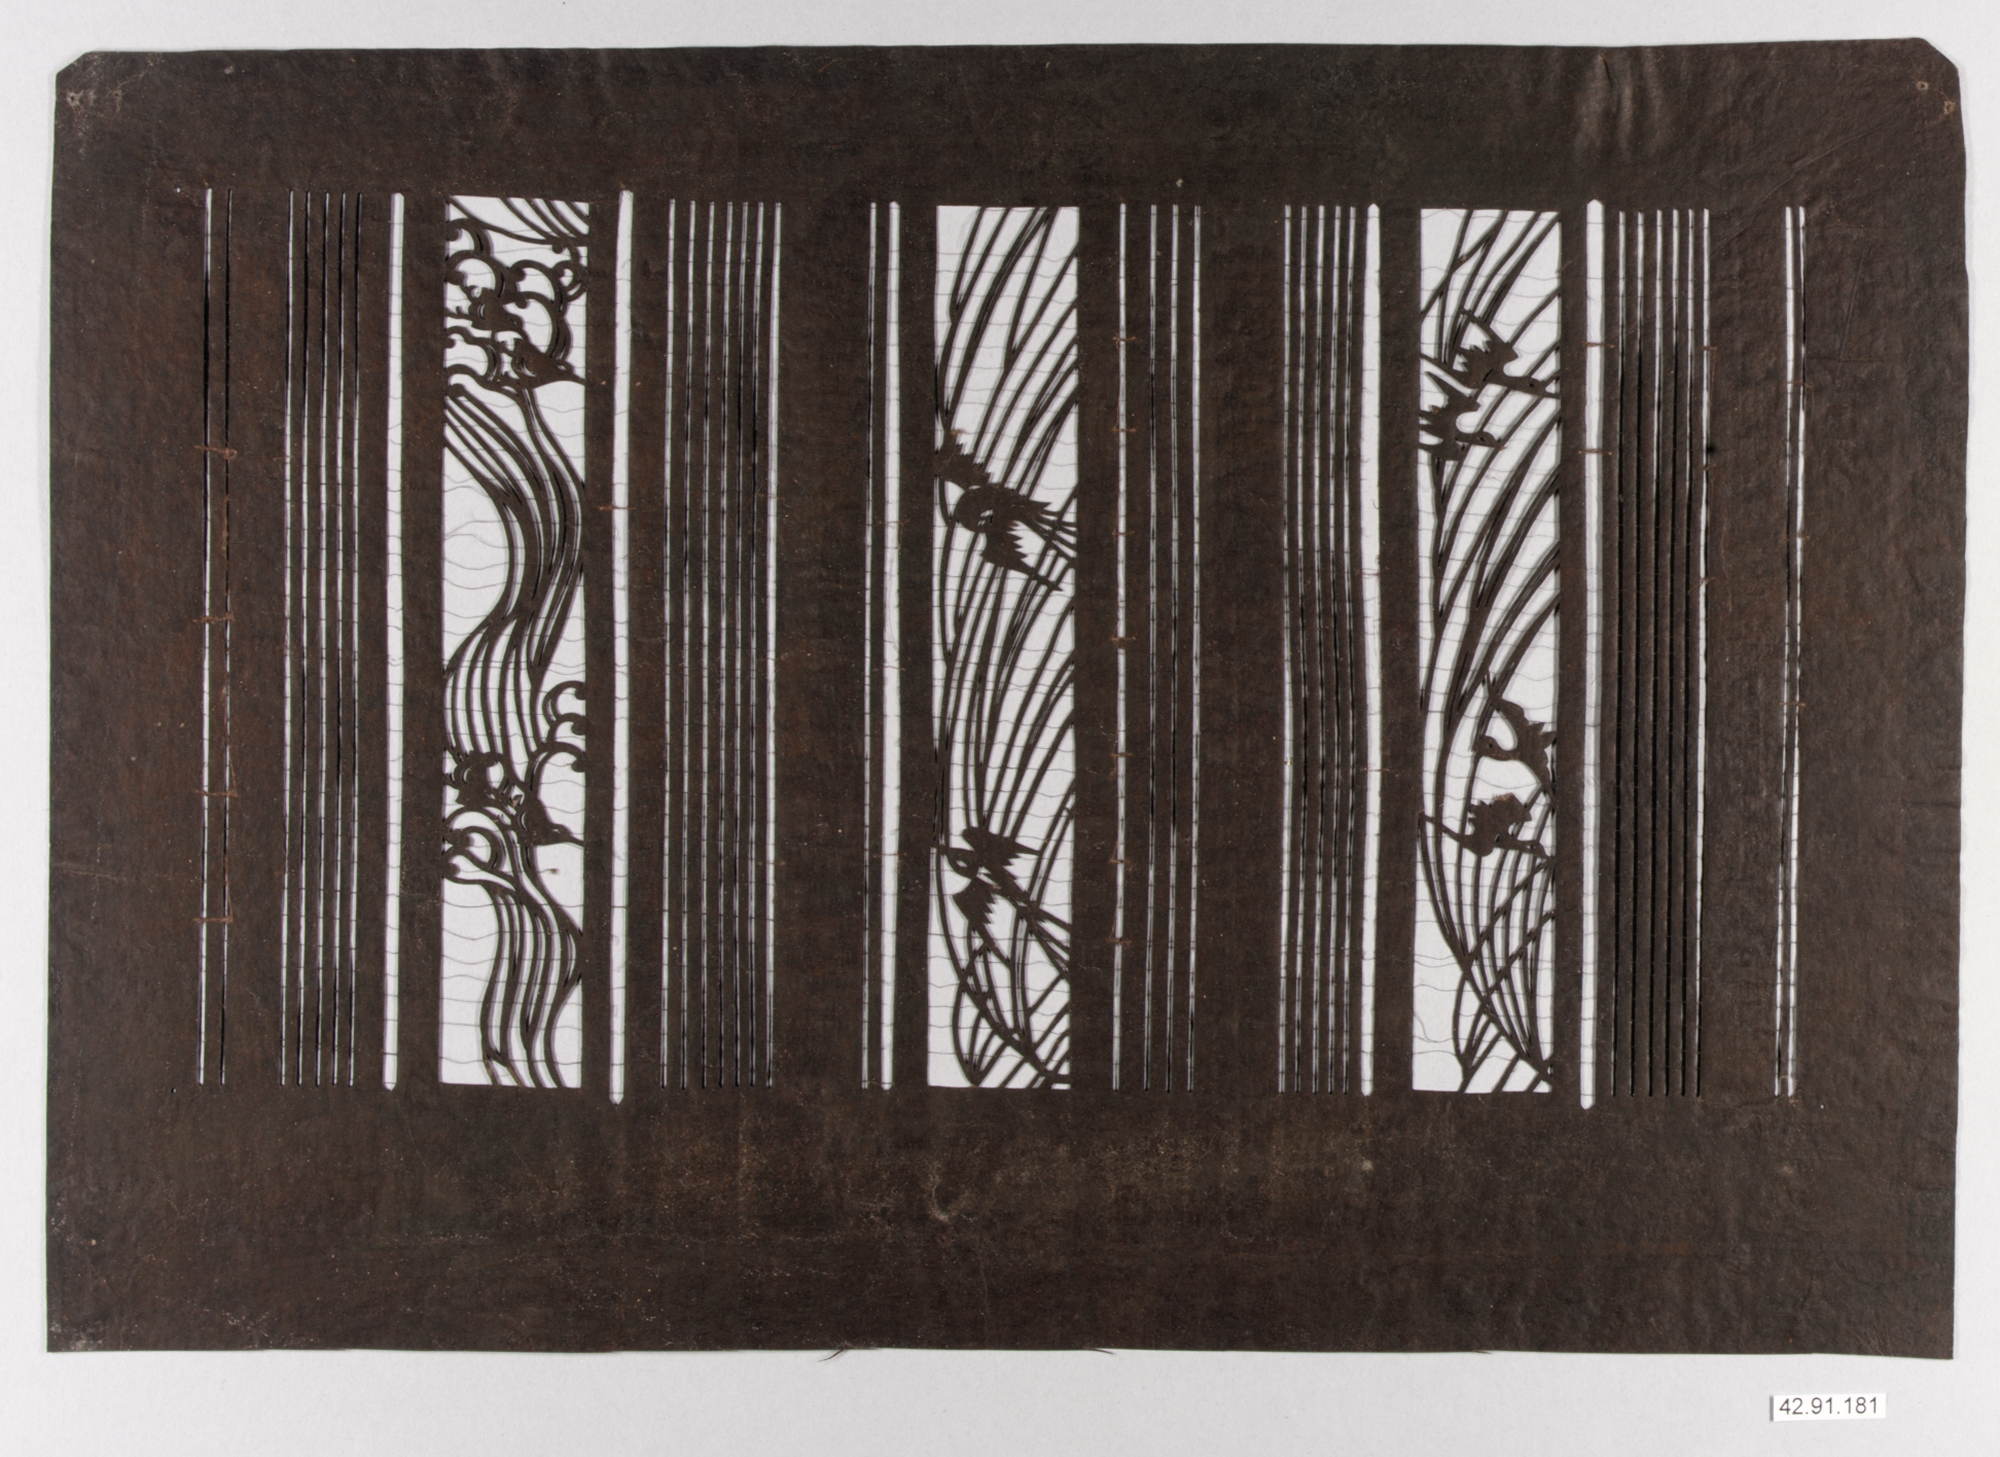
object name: stencil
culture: japanese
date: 1801-1900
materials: paper, silk